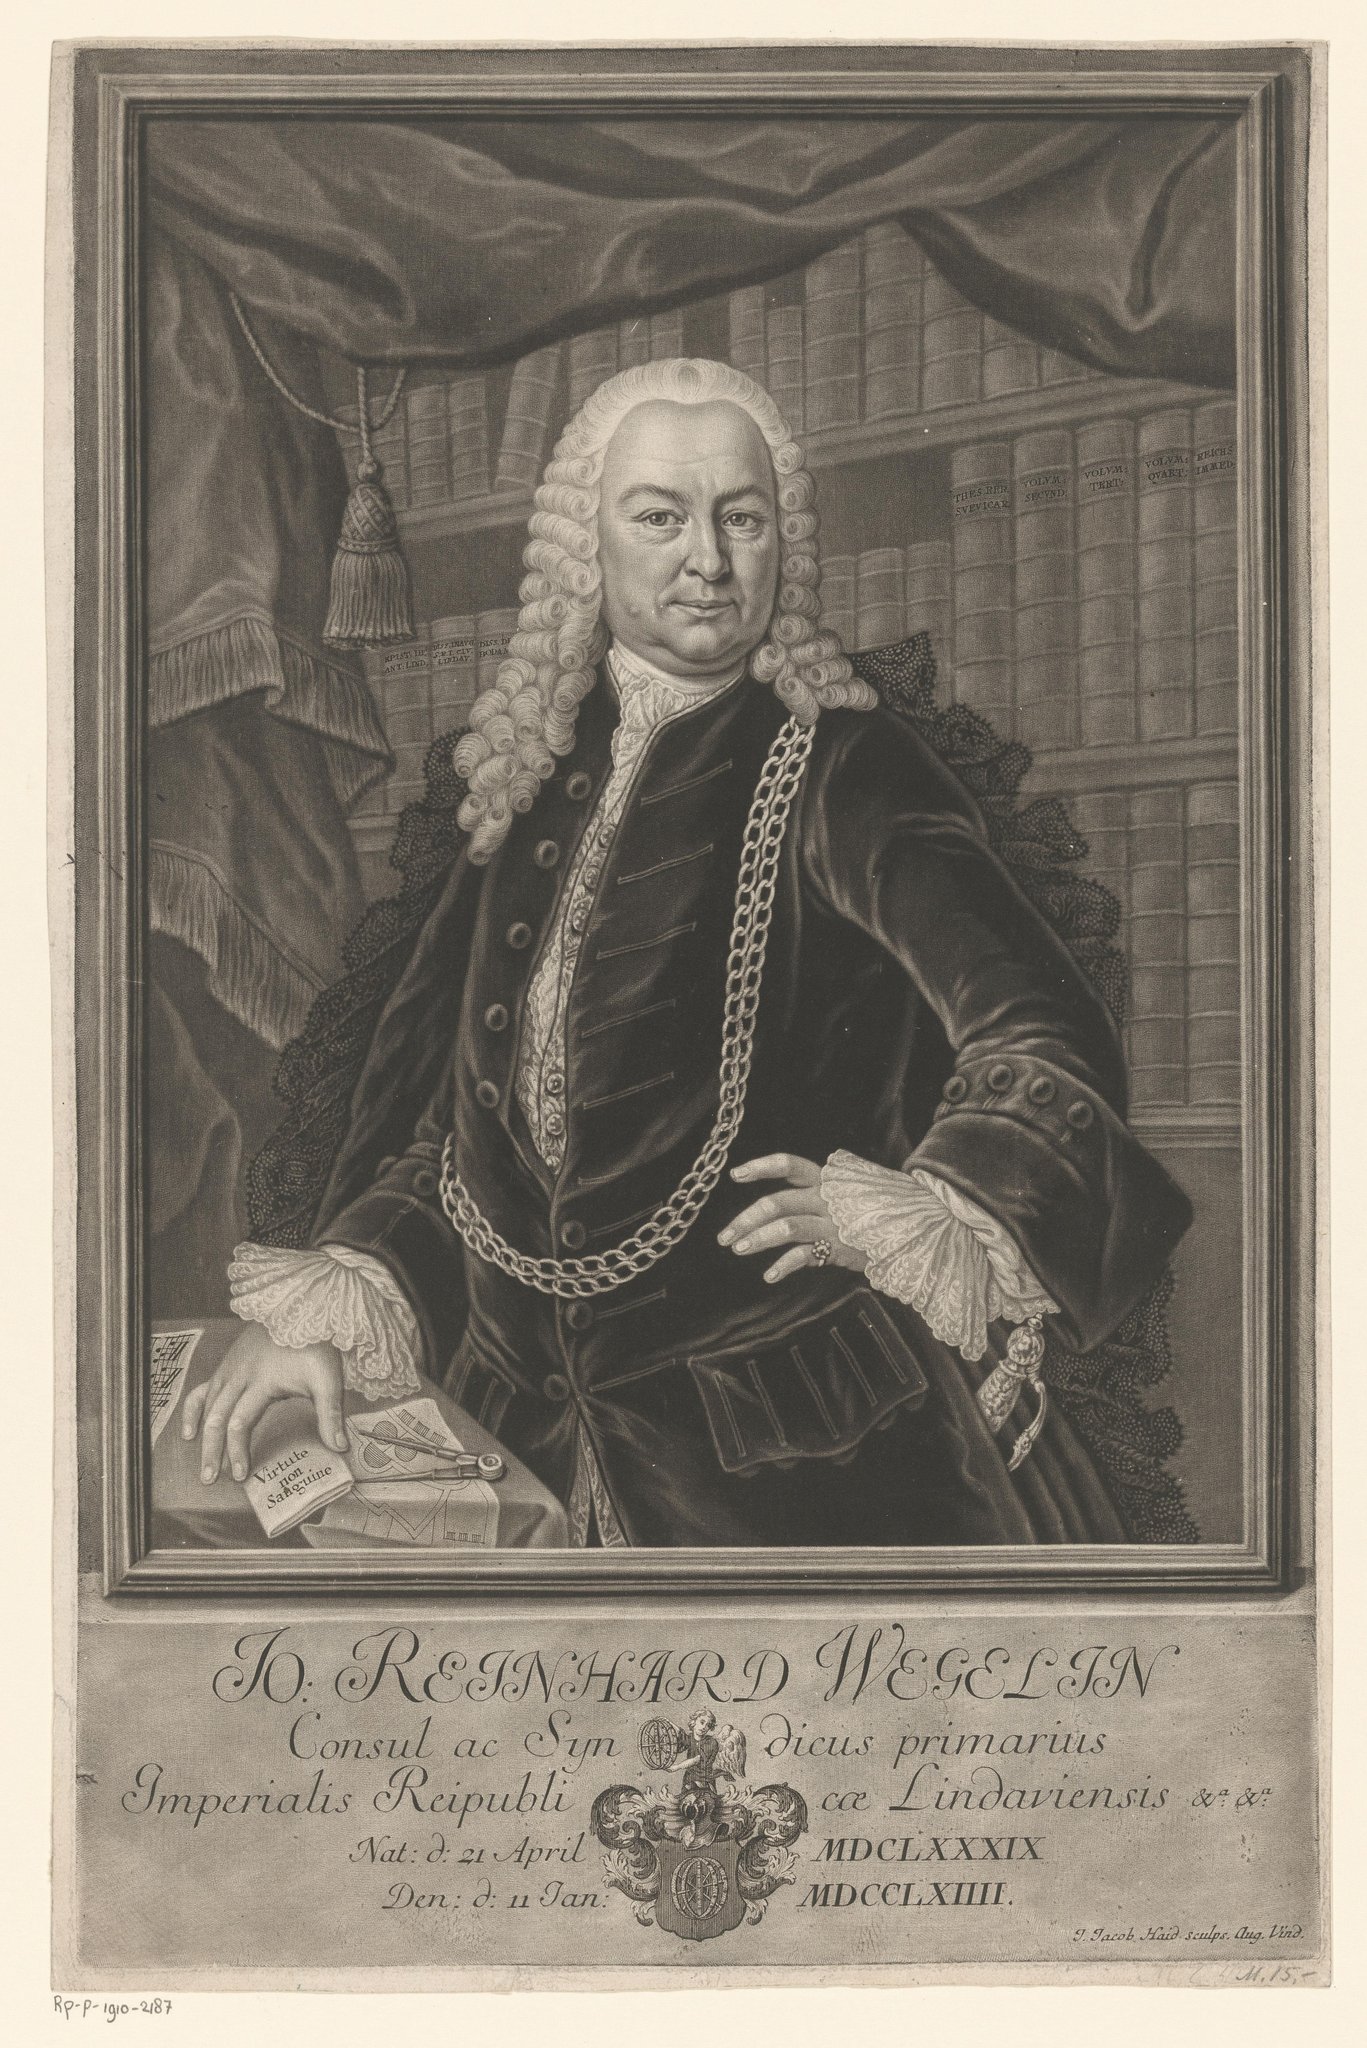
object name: print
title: Portret van Johann Reinhard Wegelin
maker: johann jacob haid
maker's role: print maker, publisher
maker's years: 1704-1767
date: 1764-1767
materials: paper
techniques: etching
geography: augsburg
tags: mayor, notation of music, bookshelves, historical persons, armorial bearing, heraldry, tools, implements of architect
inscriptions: collector's mark: Lugt 2228